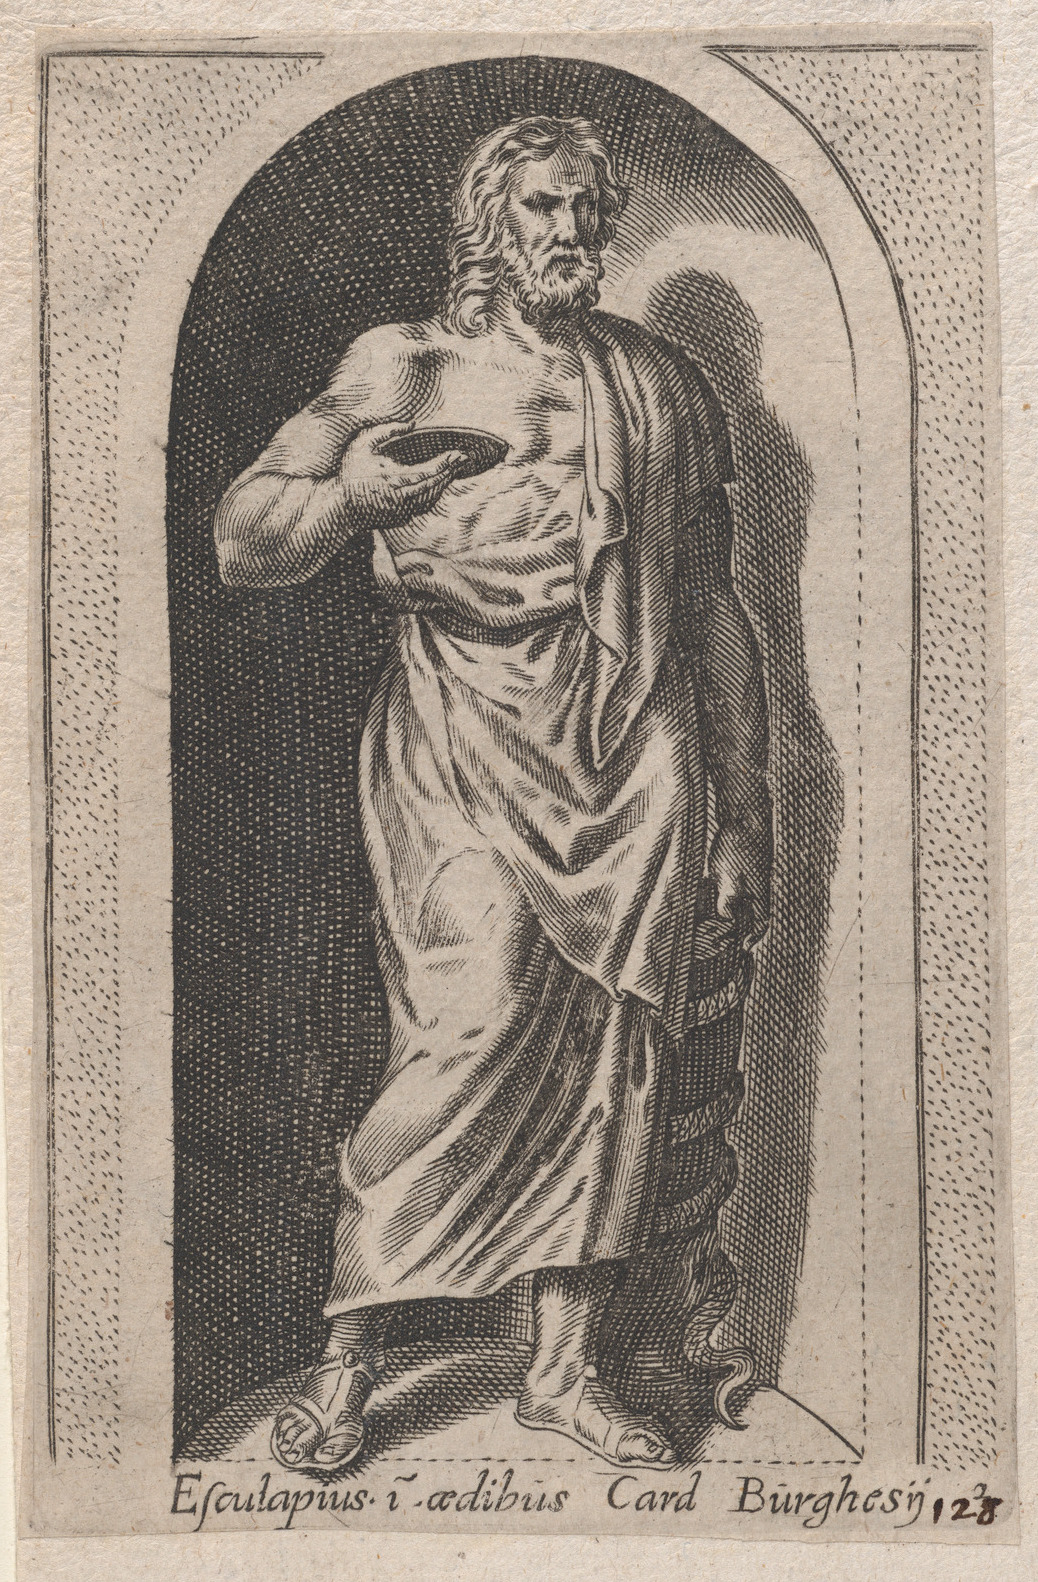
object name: print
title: Esculapius (Esculapius in aedibus Card. Burghesij), from "Speculum Romanae Magnificentiae"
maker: Anonymous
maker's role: artist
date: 1501-1600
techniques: engraving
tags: men